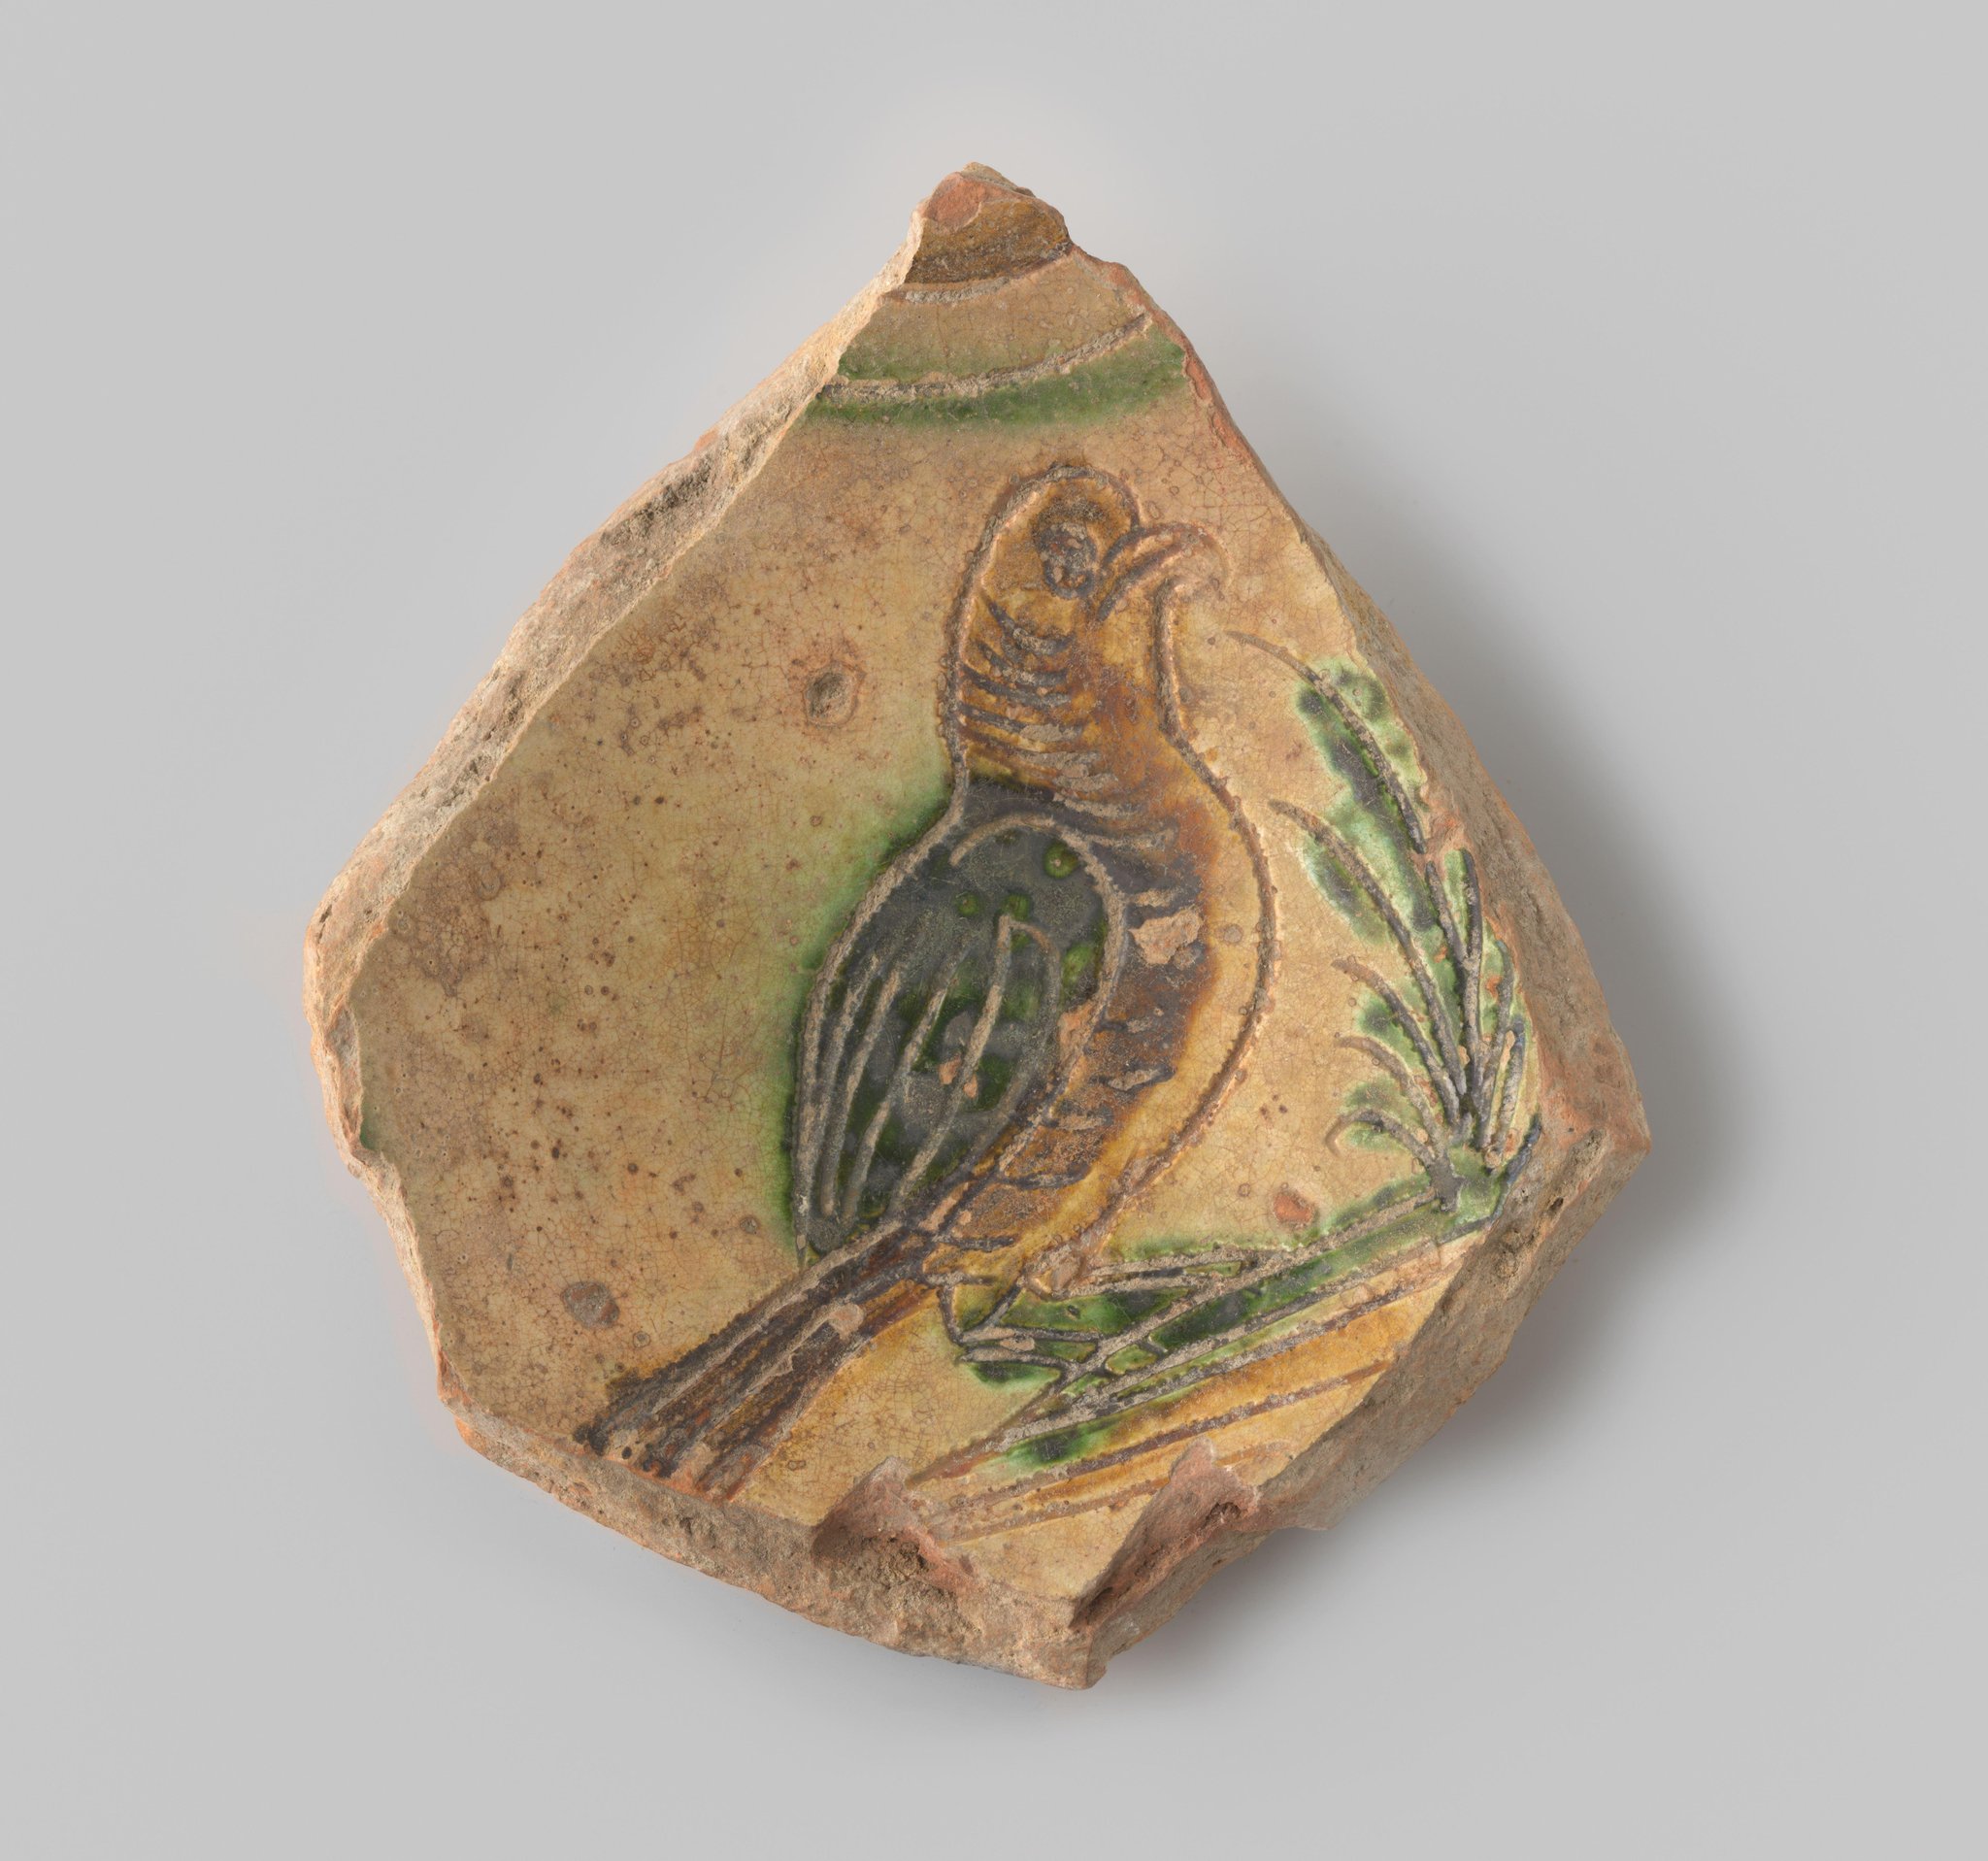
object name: sherd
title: Fragment (voet) met rode scherf, aan de binnenkant in sgraffito-techniek een vogel in groen en bruin op een tak, op een okerkleurig fond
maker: Anonymous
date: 1200-1899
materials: earthenware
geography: italy